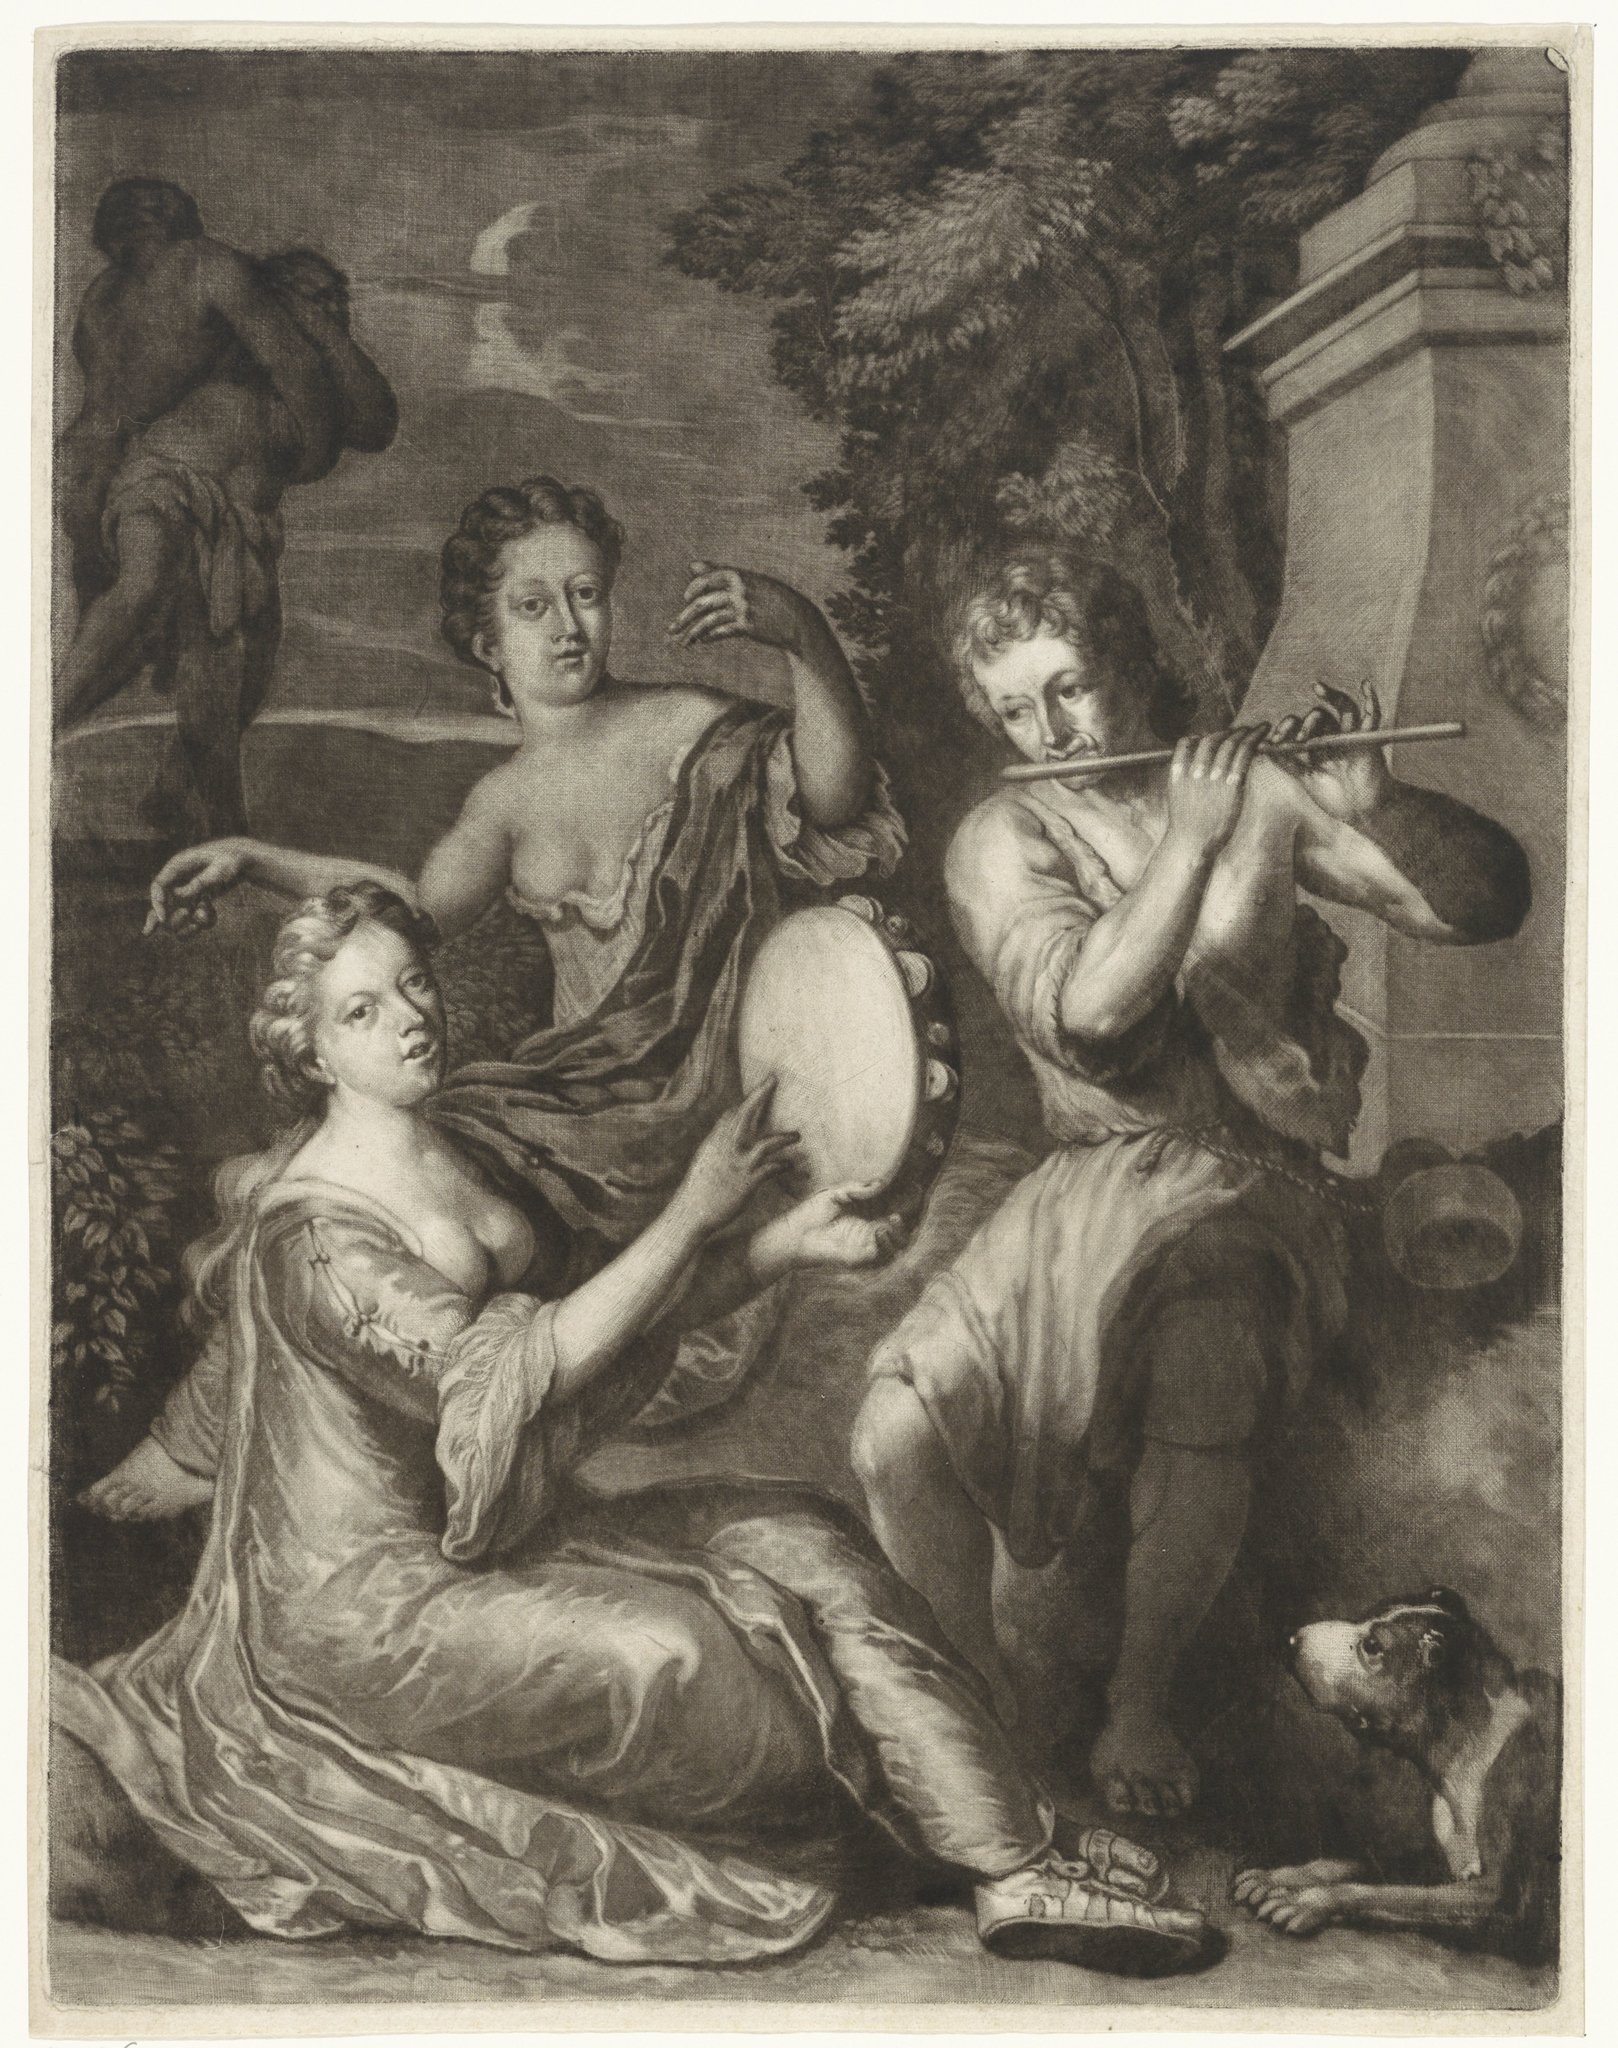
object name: print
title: Musicerend gezelschap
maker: gerard hoet (i)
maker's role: draughtsman, painter, print maker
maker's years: 1648-1733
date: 1658-1733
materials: paper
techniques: mezzotint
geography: northern netherlands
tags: tambourine, flute, aulos, tibia, dog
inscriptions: collector's mark: Lugt 2228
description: Een man en twee vrouwen maken muziek in een park. De man bespeelt een fluit terwijl een van de vrouwen op een tamboerijn slaat en zingt. Op de achtergrond een sculptuur.